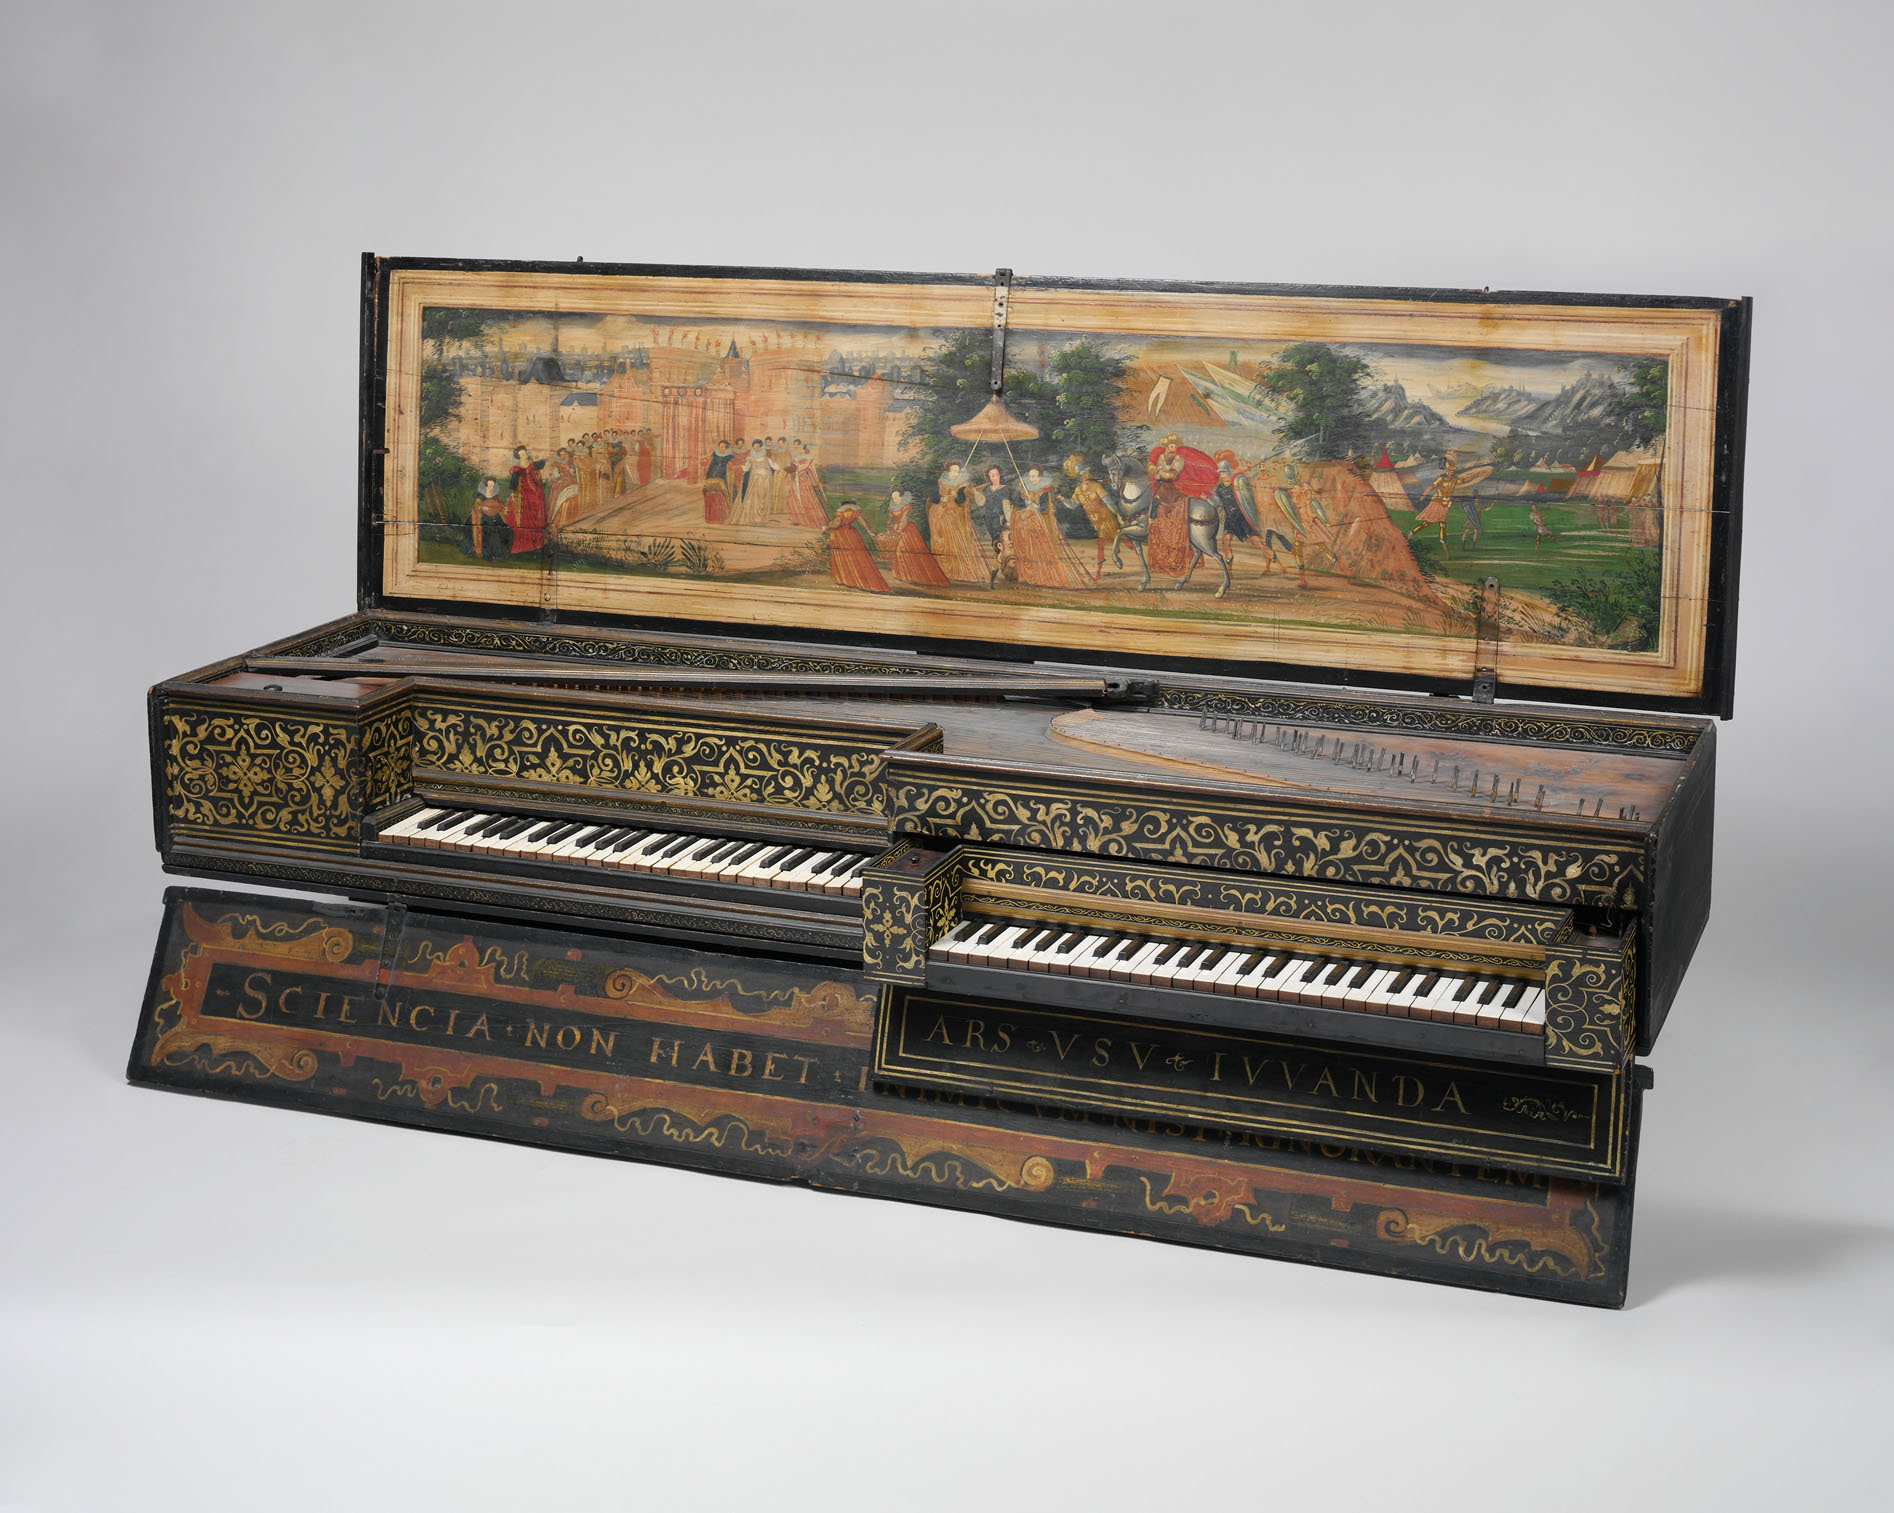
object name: double virginal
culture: flemish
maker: lodewijck grouwels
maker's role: maker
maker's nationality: flemish, active the netherlands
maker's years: 1593-1600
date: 1600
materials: ivory, paint, wood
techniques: gilding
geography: netherlands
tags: men,women,horses,crowd